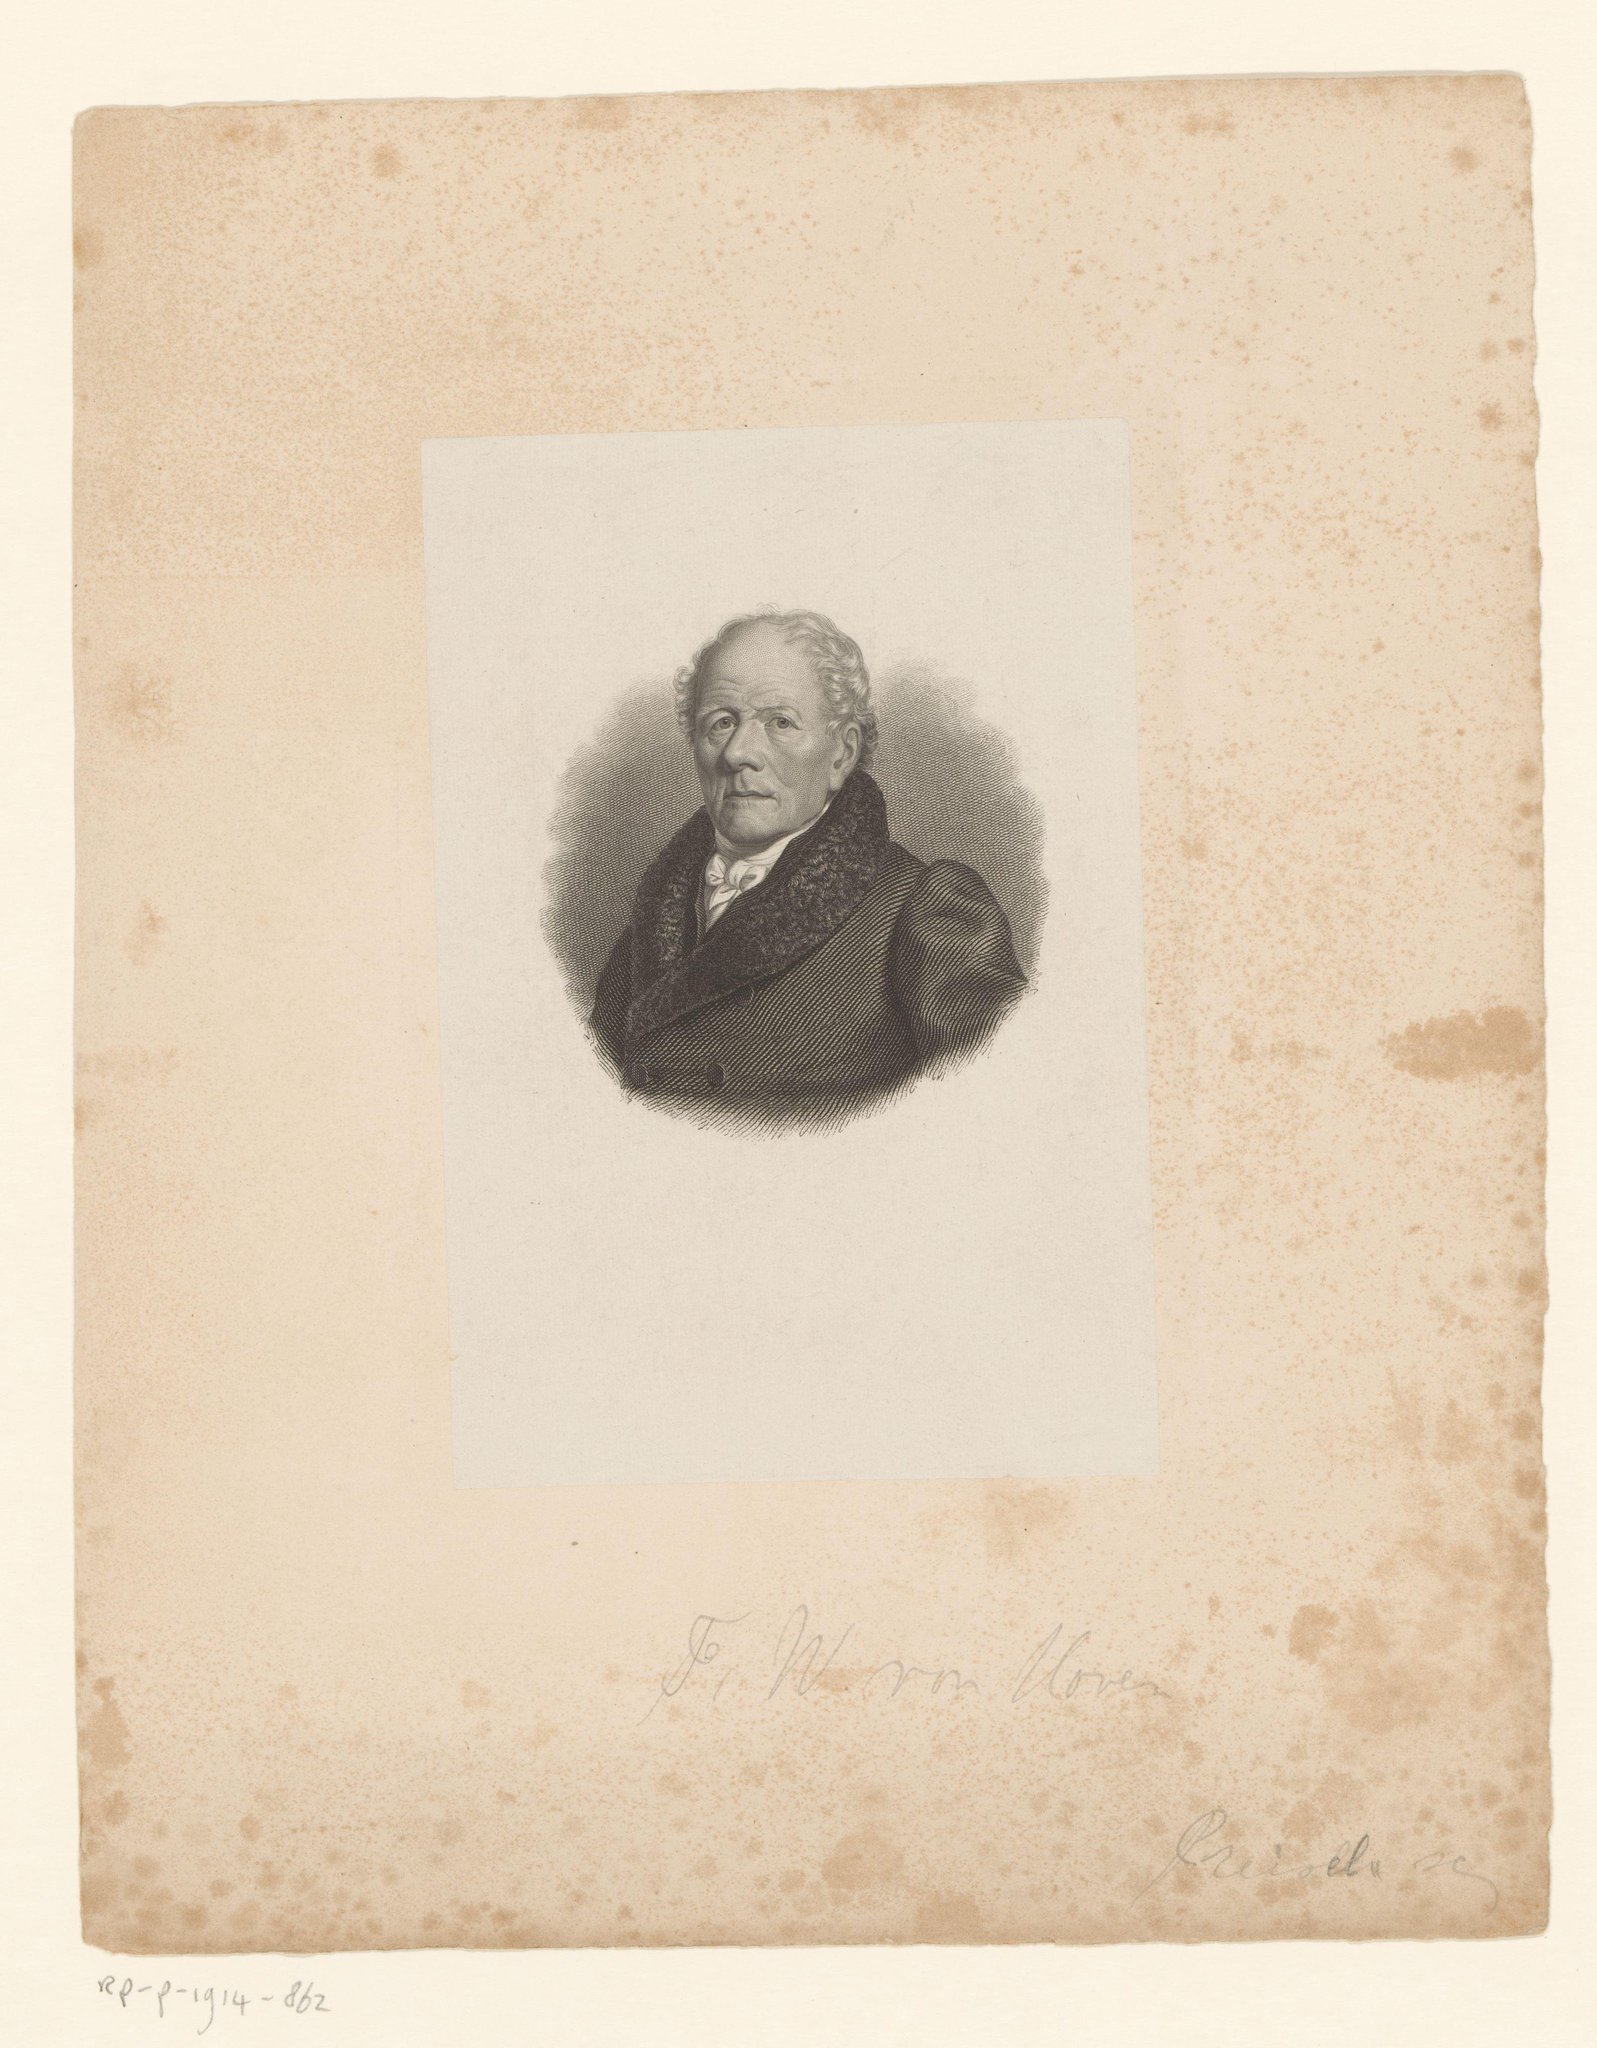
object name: print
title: Portret van Friedrich Wilhelm von Hoven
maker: christoph preisel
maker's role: artist, print maker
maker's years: 1818-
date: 1828-1914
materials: paper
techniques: engraving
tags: historical persons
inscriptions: name, collector's mark: Lugt 2228, name